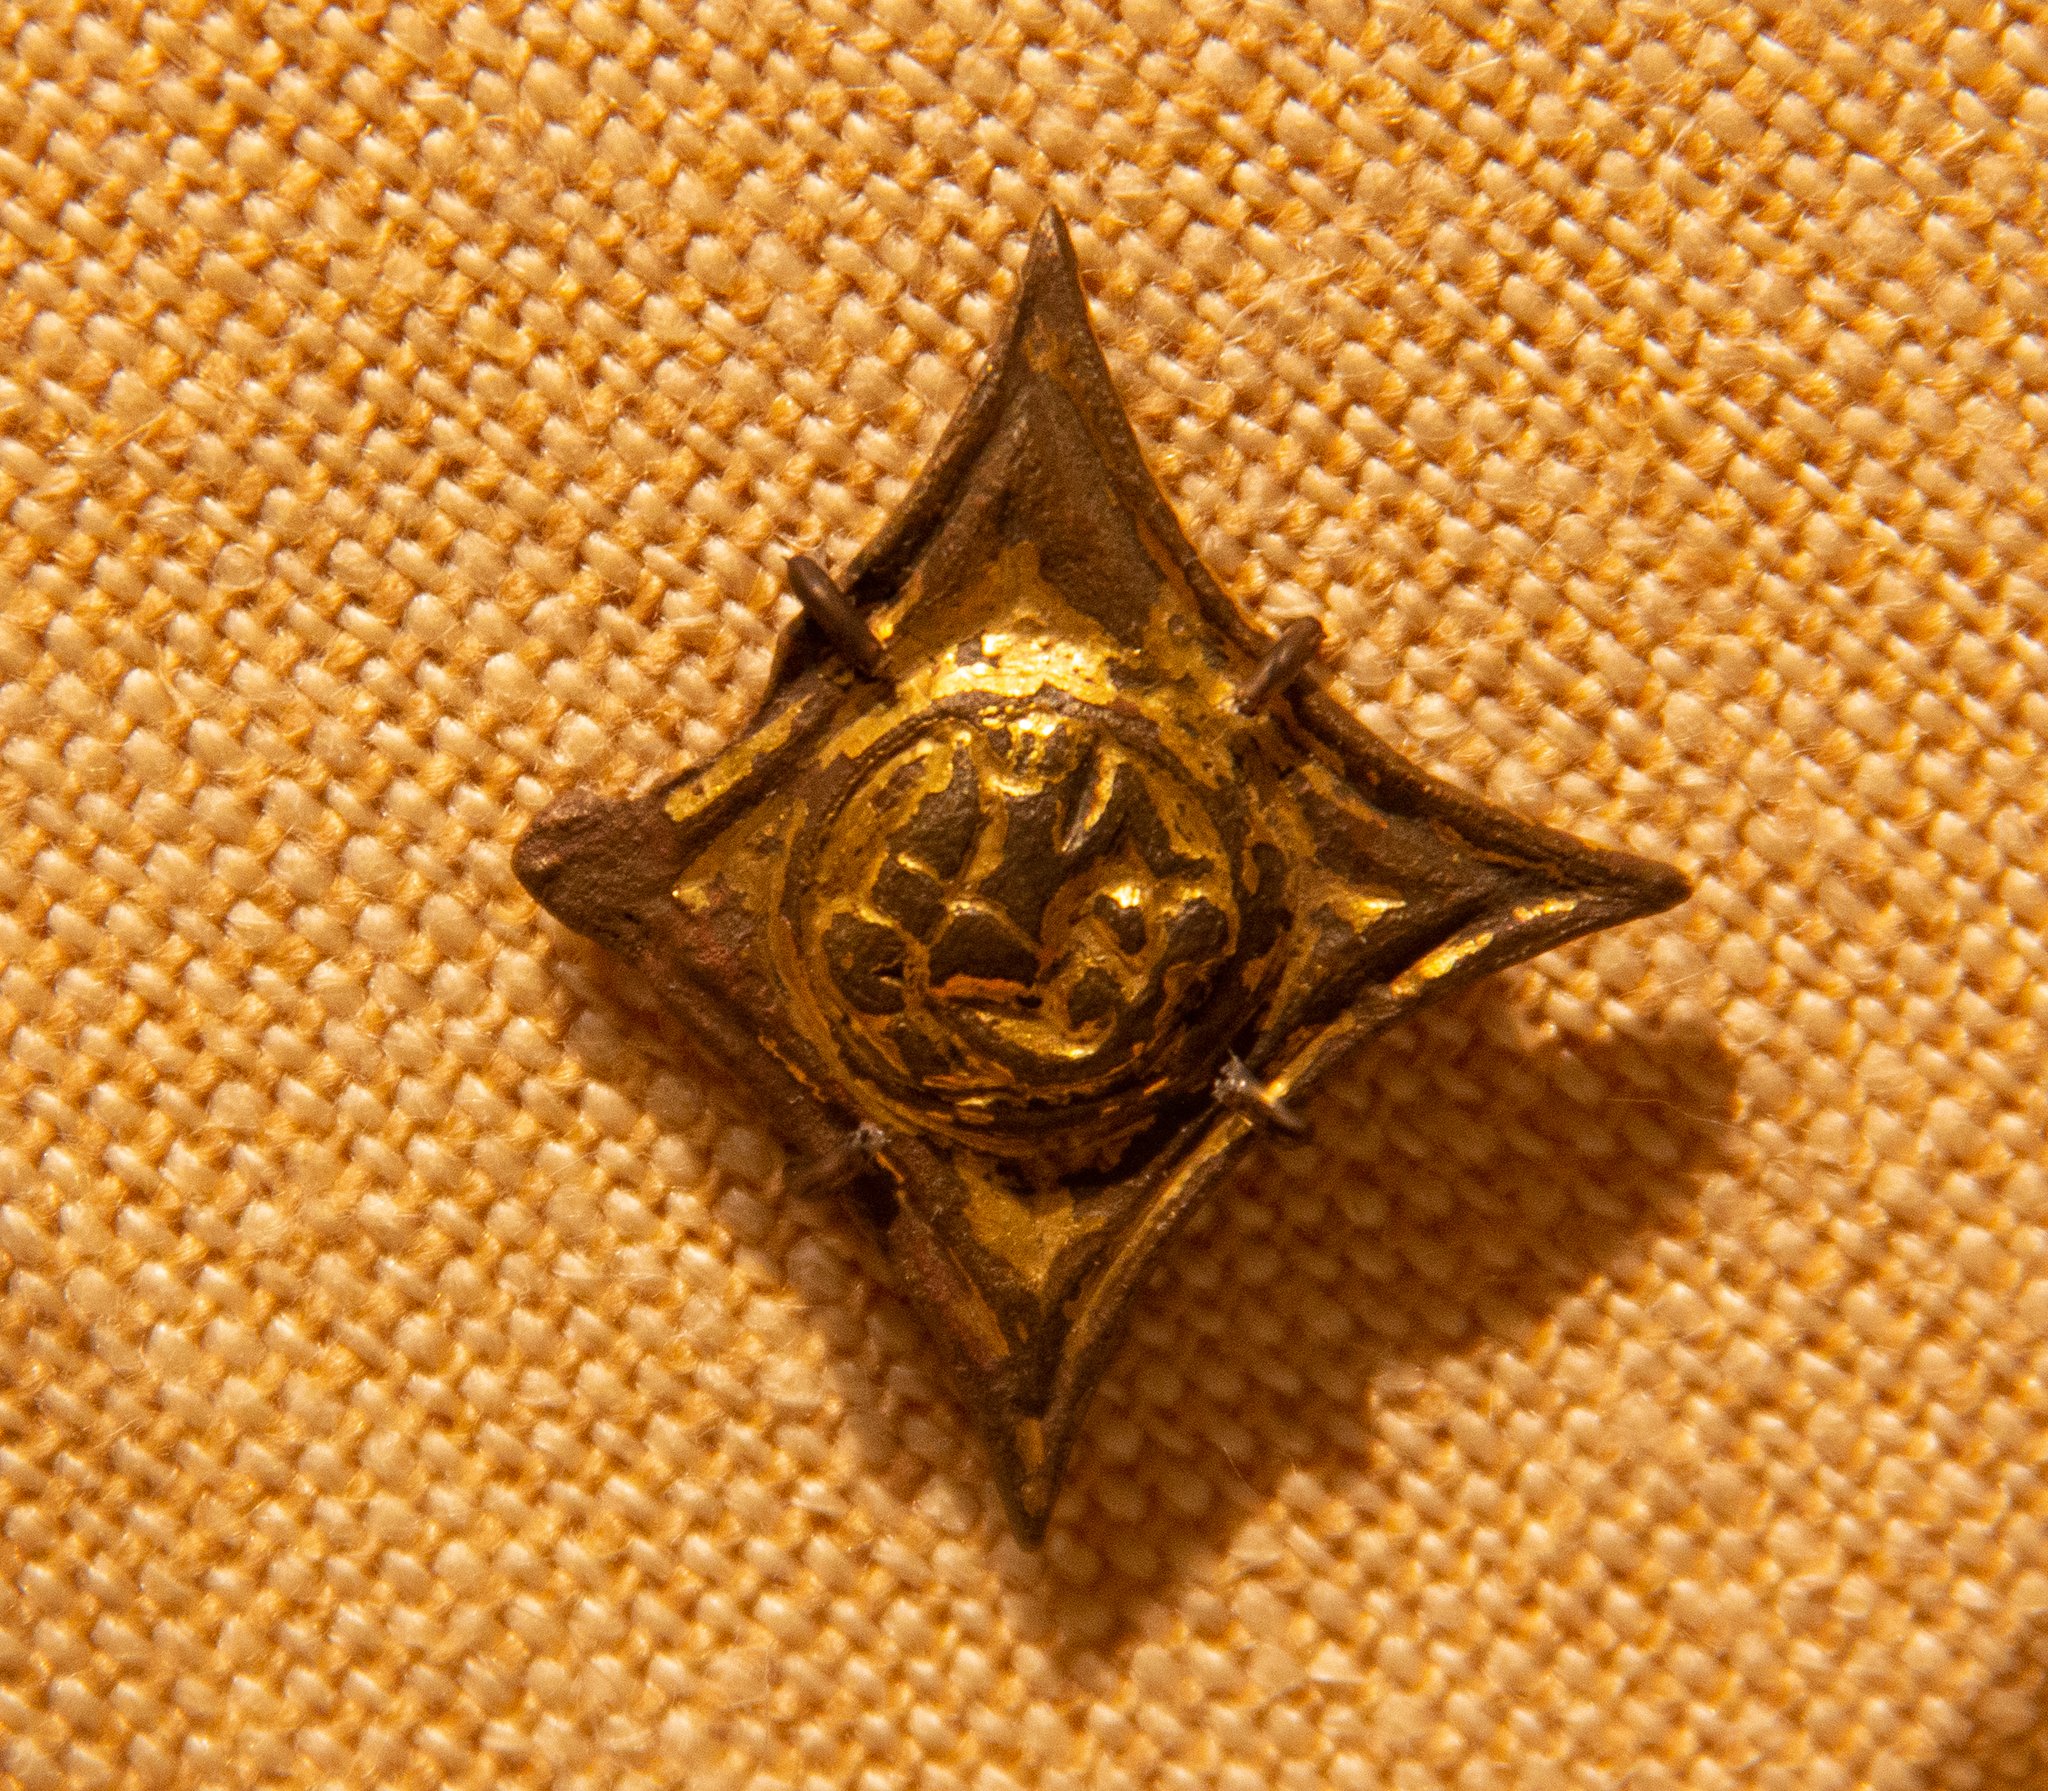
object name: belt fitting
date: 801-1000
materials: bronze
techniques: casting, gilding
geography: iran